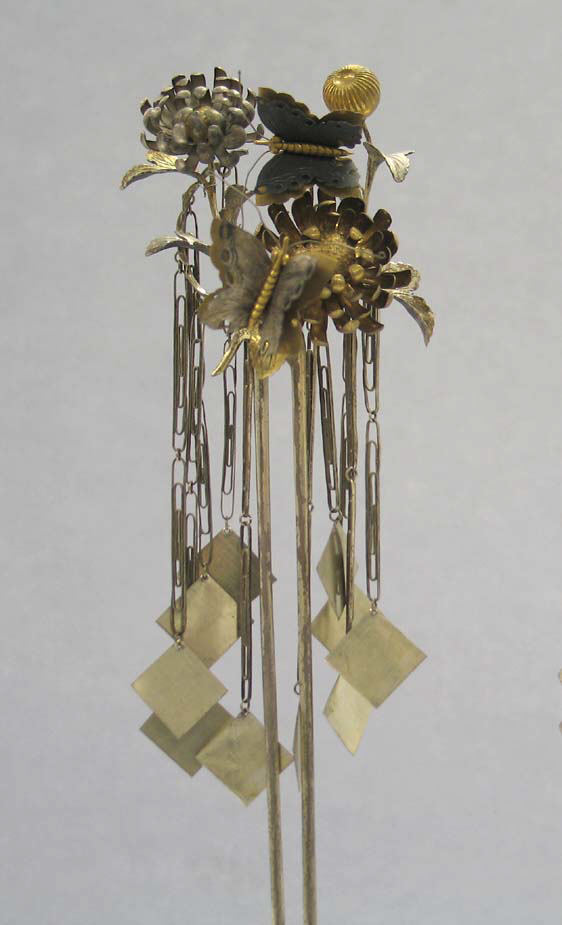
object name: hair ornament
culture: japanese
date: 1867-1900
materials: metal, silver, silver gilt